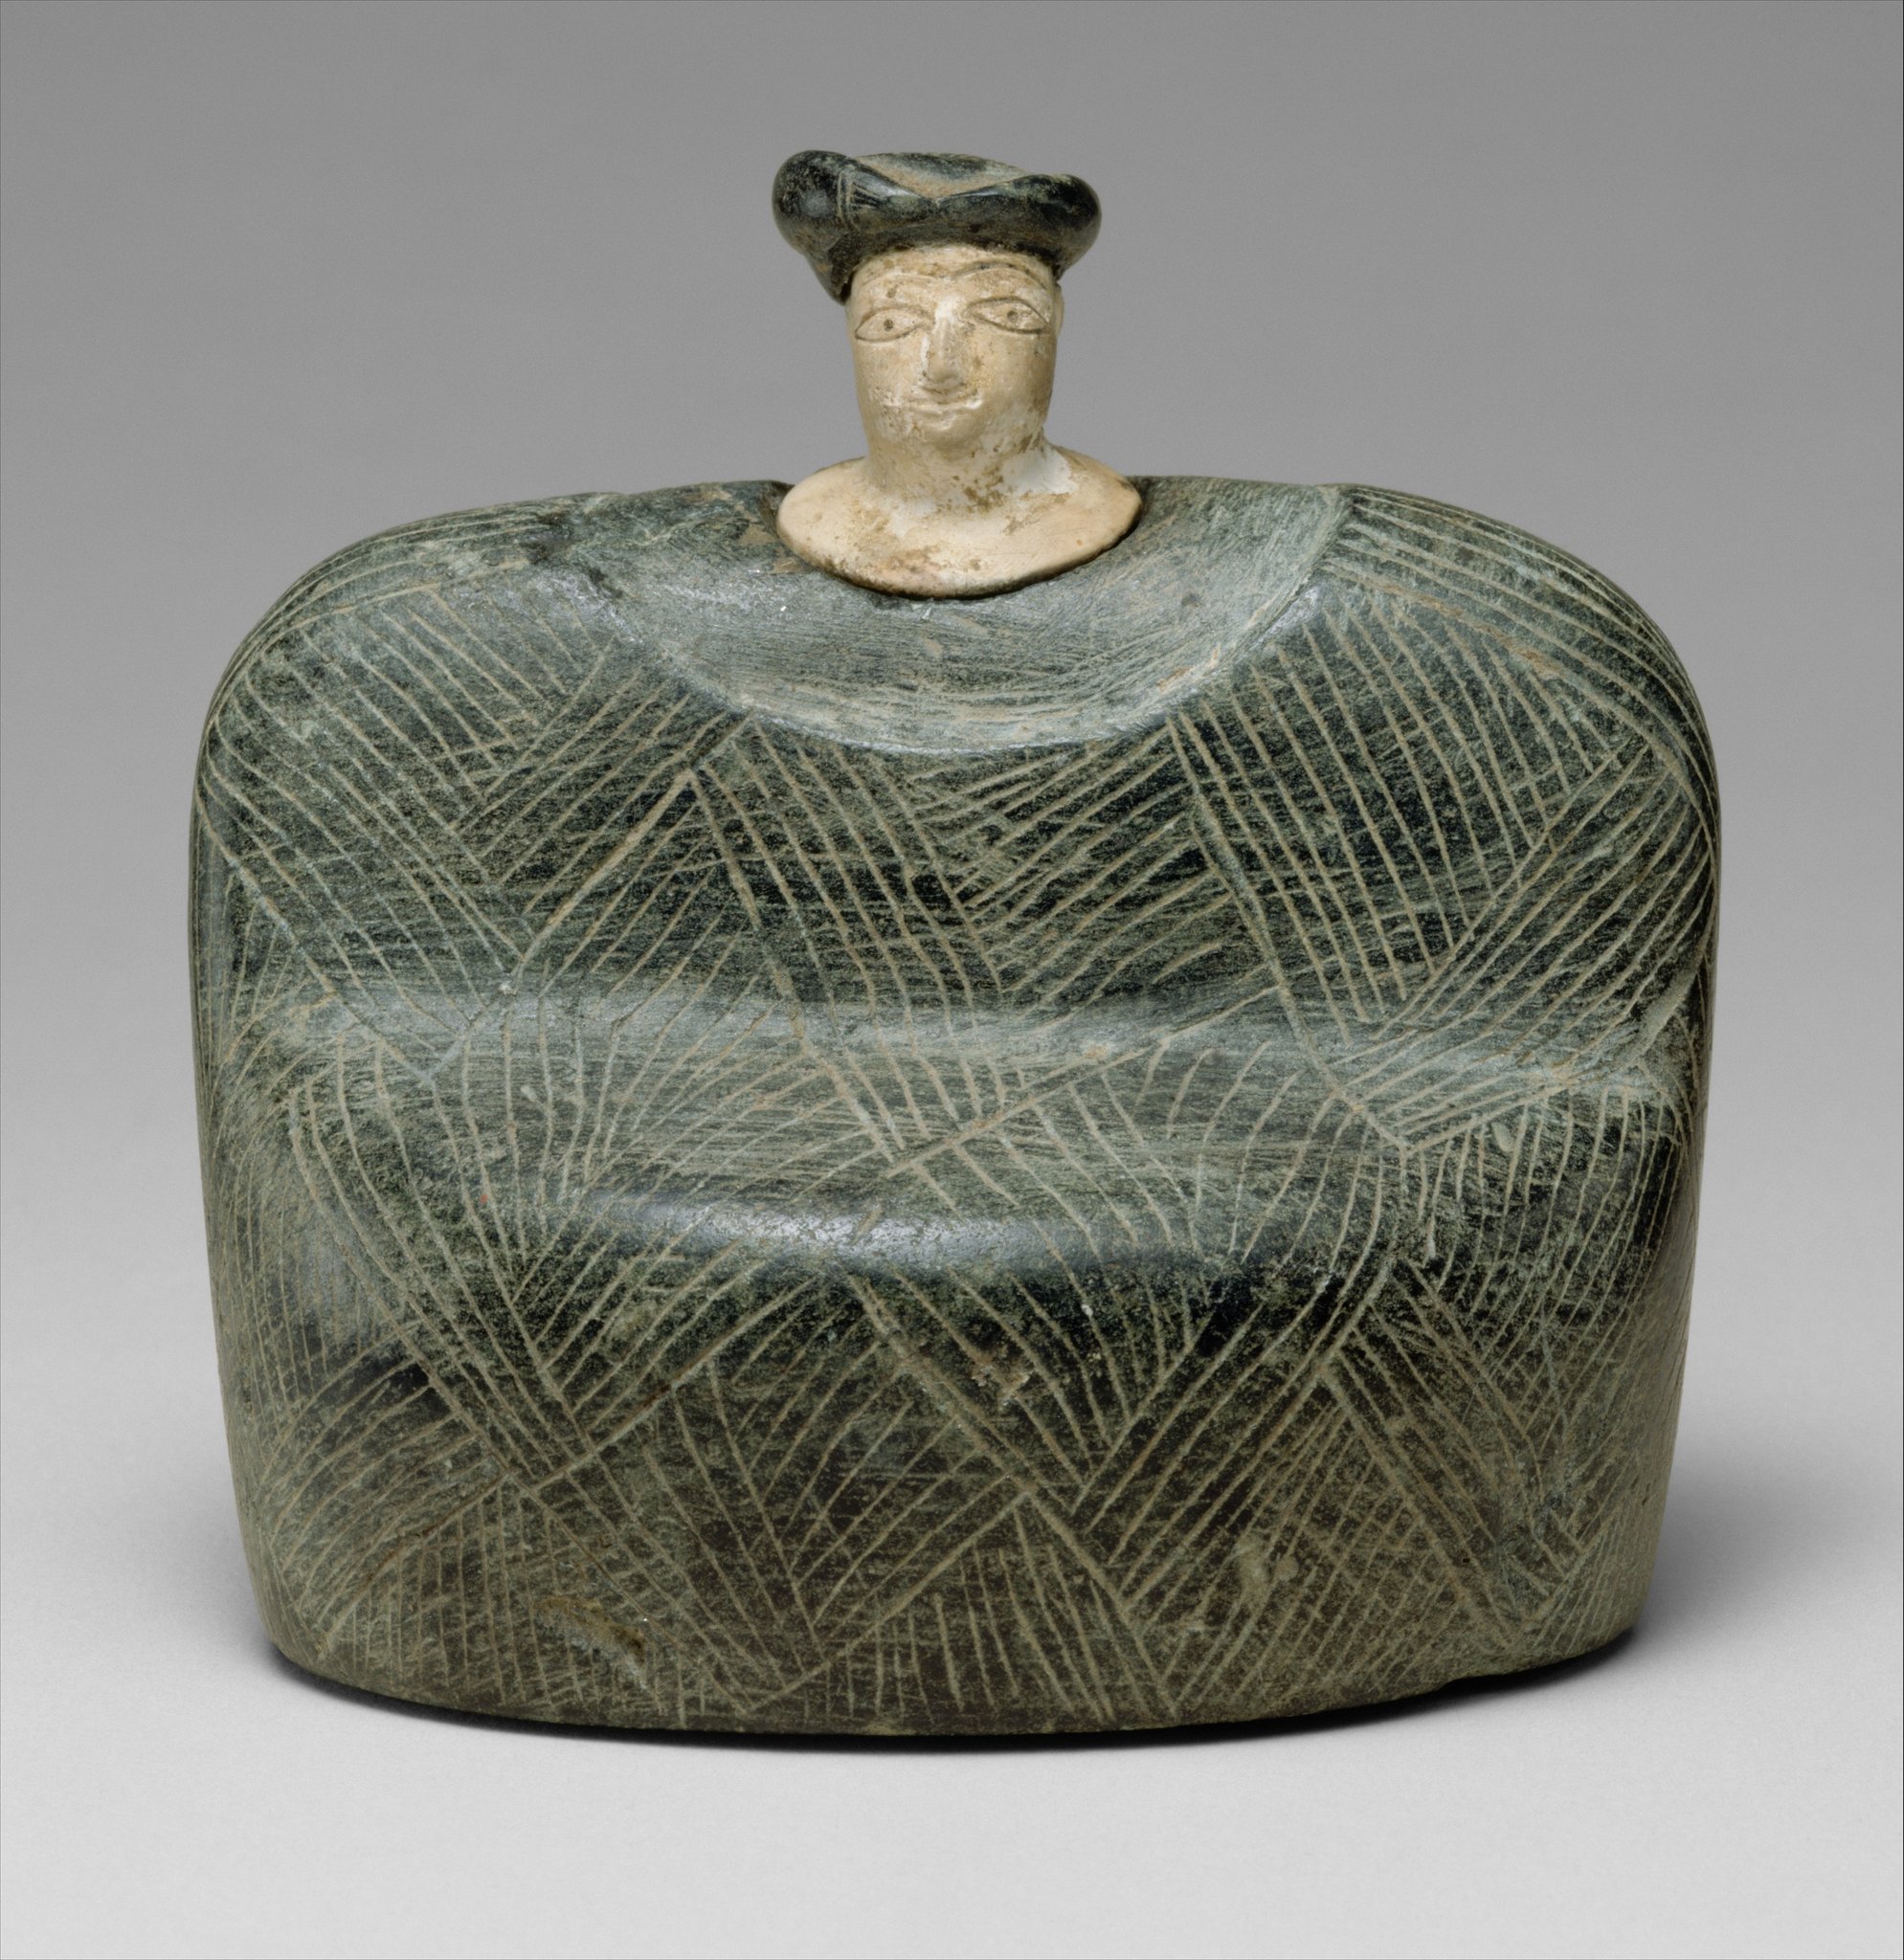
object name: sculpture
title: Seated female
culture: bactria-margiana archaeological complex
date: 2333-1668 BCE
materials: alabaster, mineral, stone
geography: bactria-margiana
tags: women